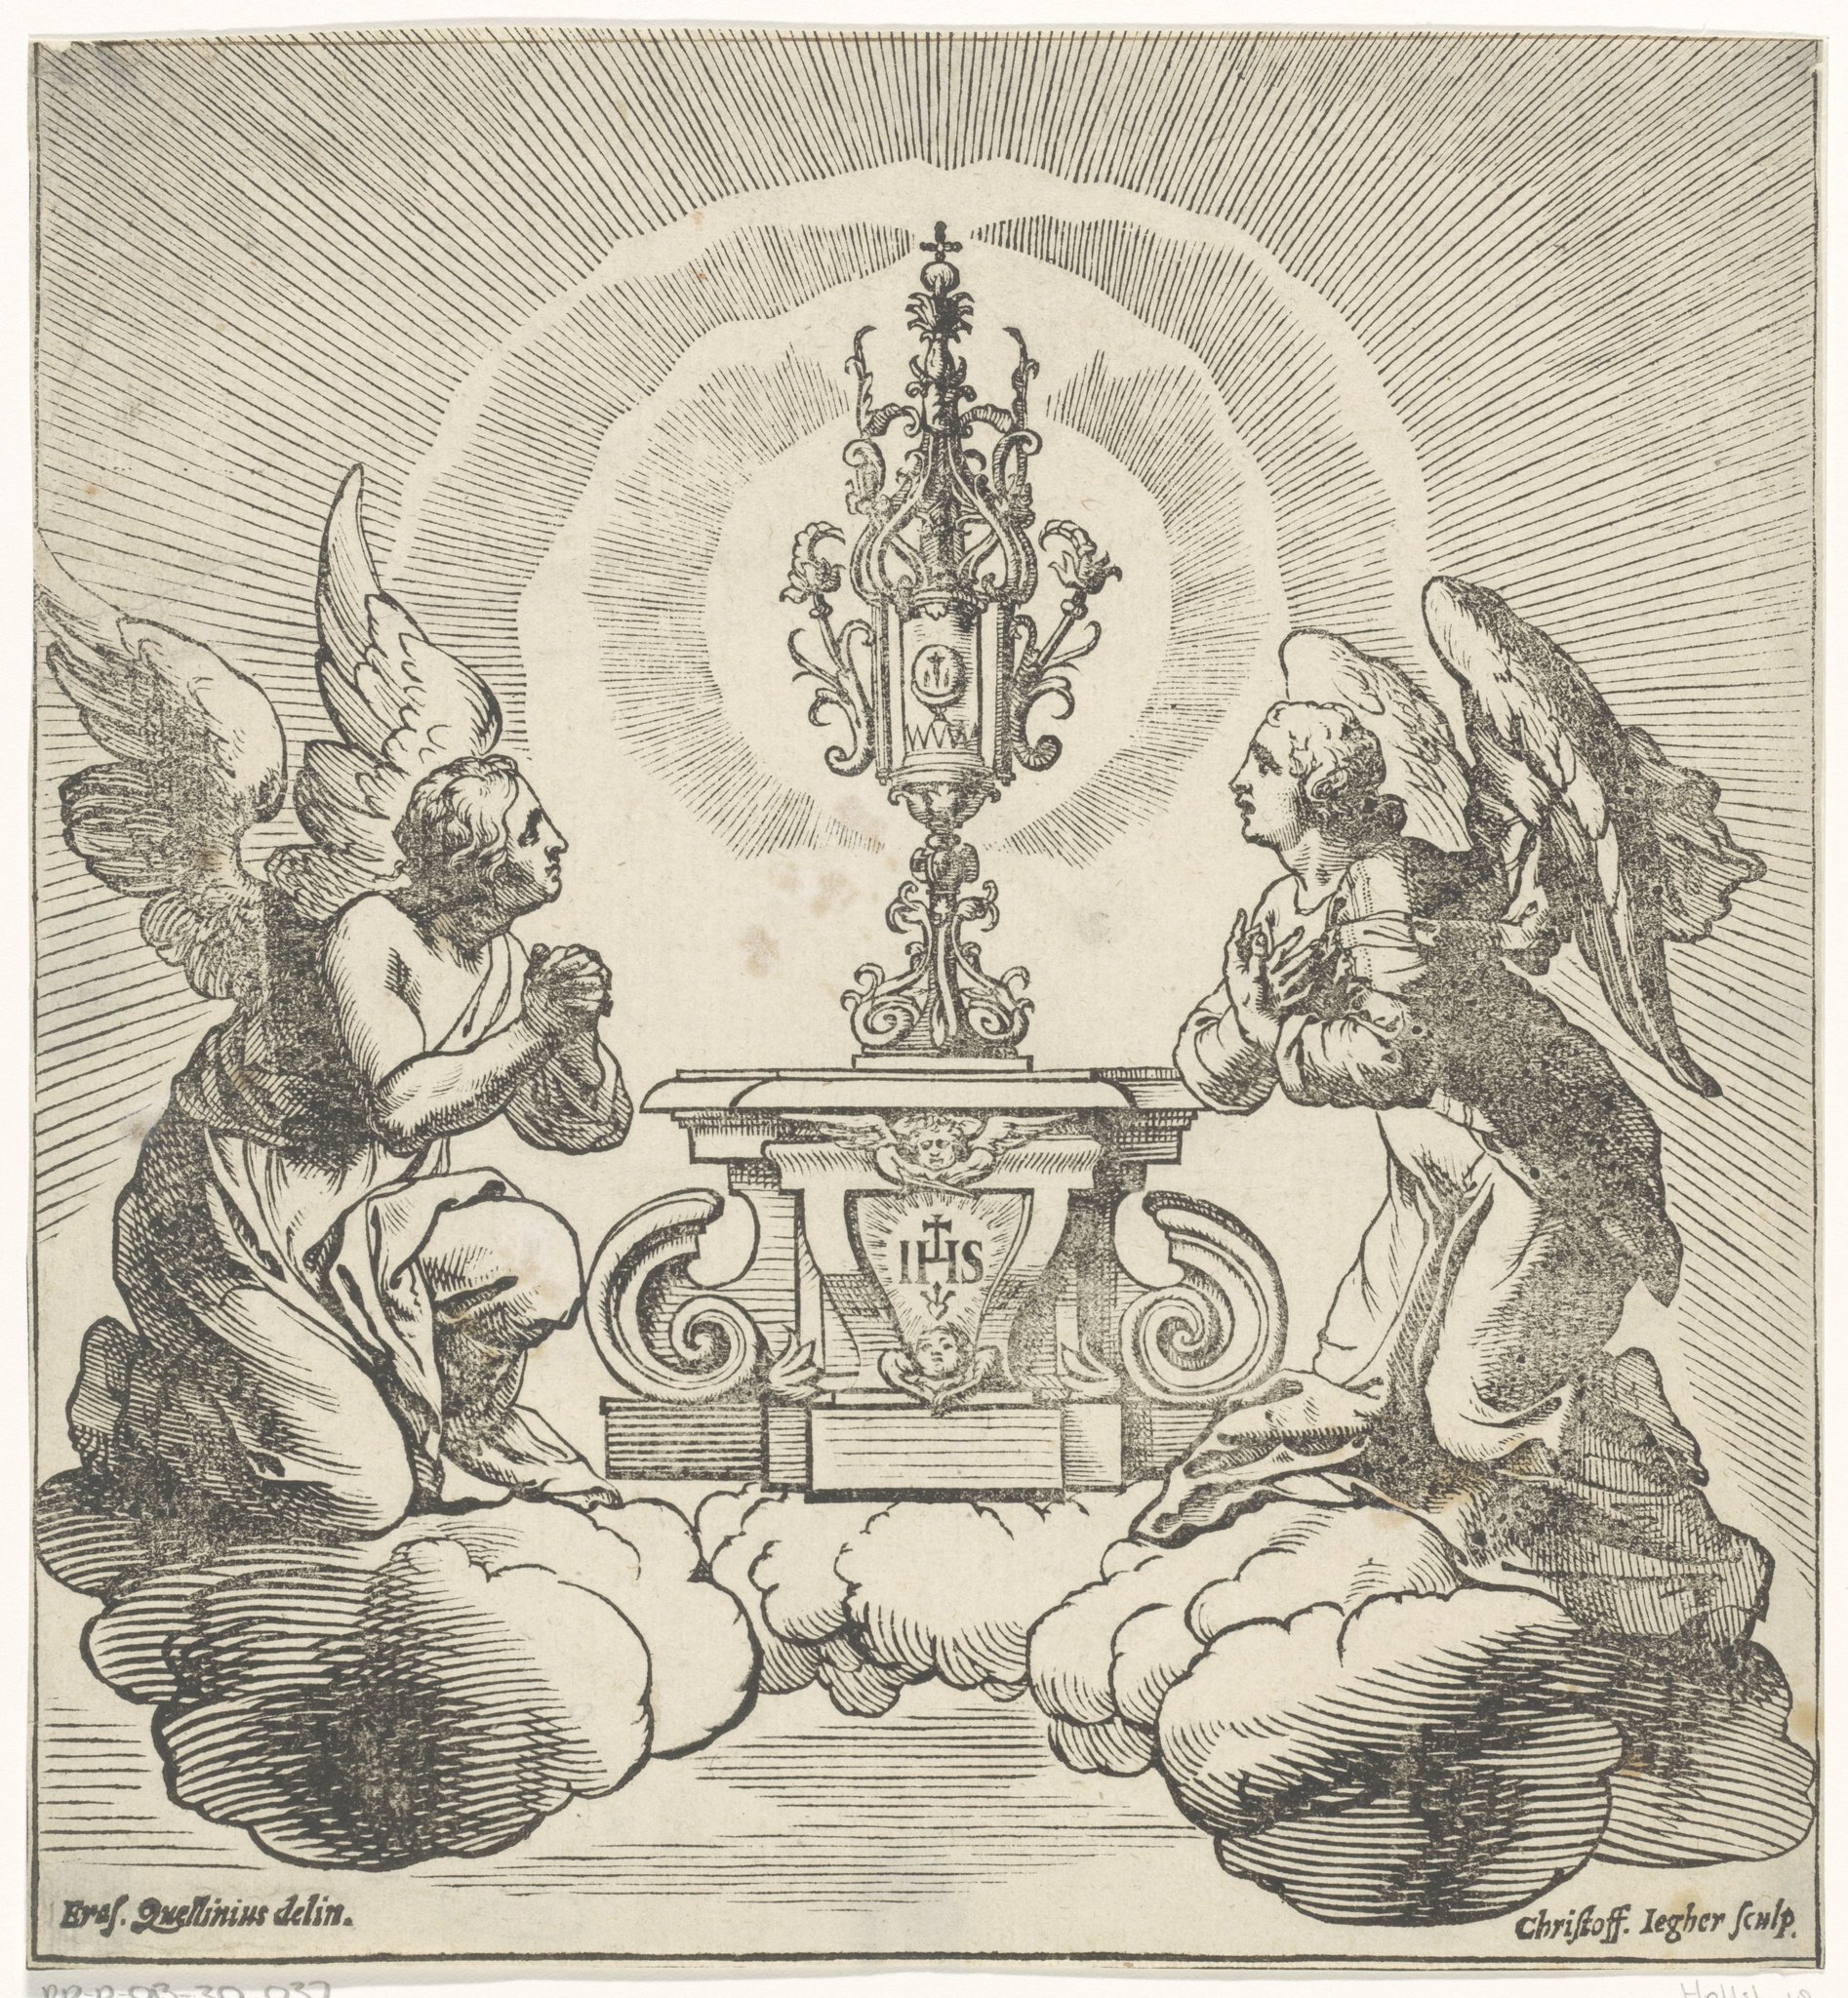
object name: print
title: Twee engelen aanbidden de hostie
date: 1632-1653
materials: paper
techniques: woodcut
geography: southern netherlands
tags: bread, host, angels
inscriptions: collector's mark: Lugt 2228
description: Twee engelen knielen op wolken aan weerszijden van de hostie.